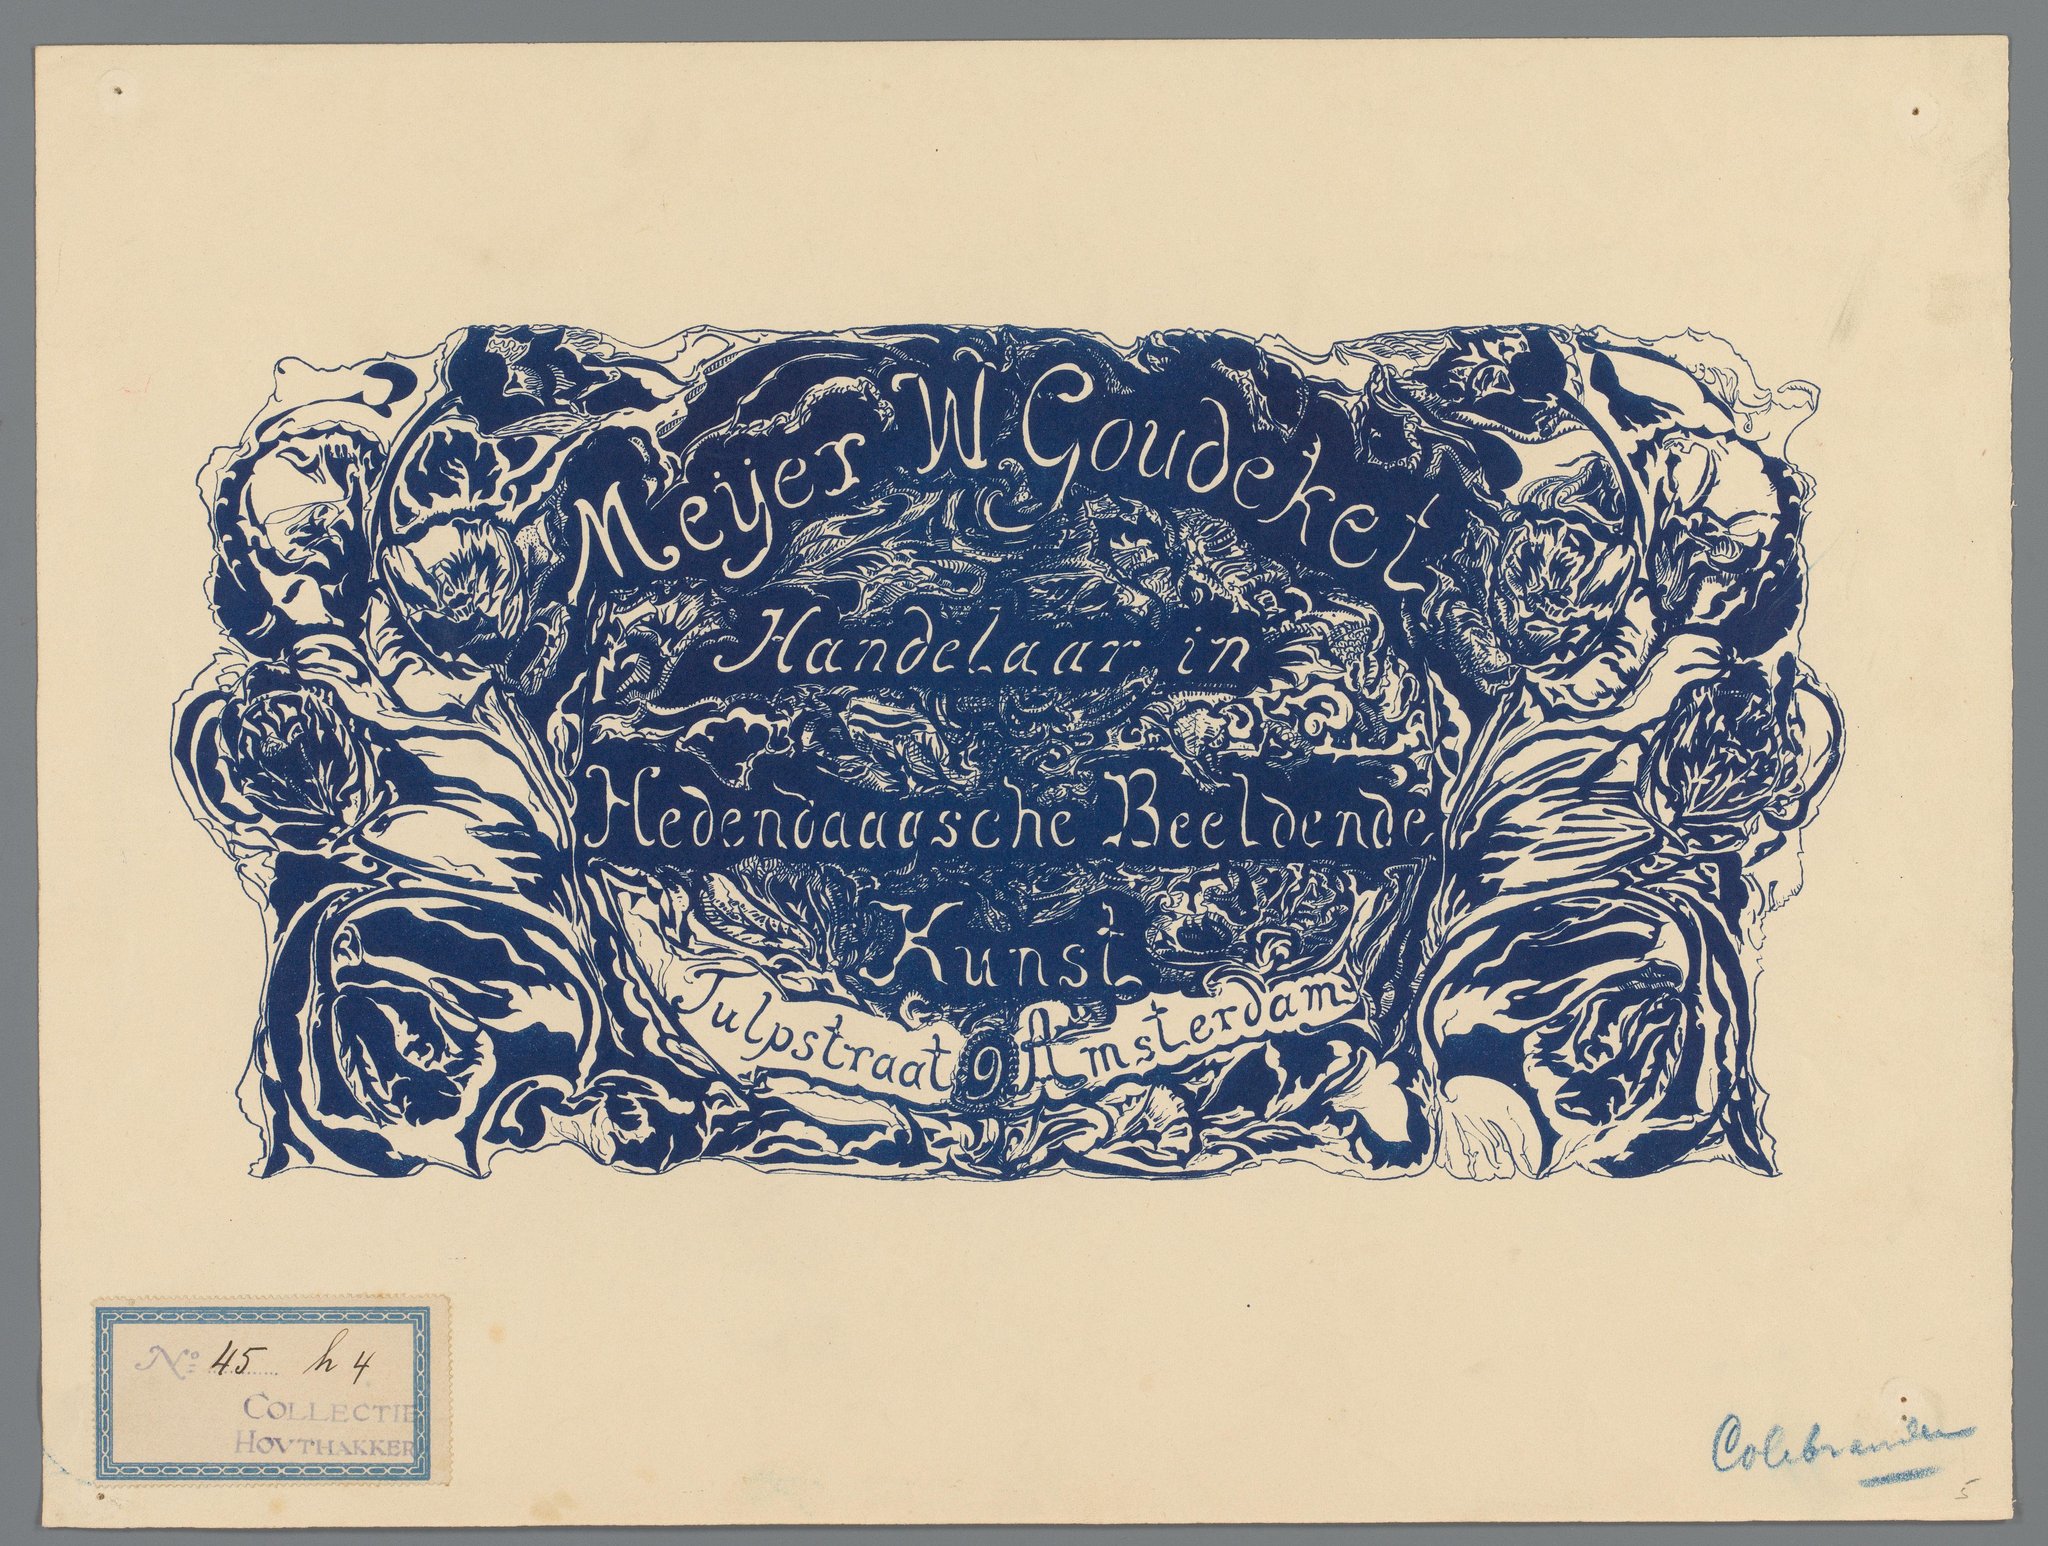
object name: advertisement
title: Advertentie of reclamebiljet voor kunsthandelaar Meijer W. Goudeket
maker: theo colenbrander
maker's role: draughtsman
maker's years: 1841-1930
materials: paper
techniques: lithograph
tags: publisher, meijer goudeket, plants (in general), ornament derived from plant forms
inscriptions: collector's mark: Lugt 2166, collector's mark: ‘No. 45 h 4 Collectie Hovthakker’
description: Links en rechts bloemen. In het midden bladeren met de tekst: 'Meijer W. Goudeket Handelaar in Hedendaagsche Beeldende Kunst Tulpstraat 9 Amsterdam'.